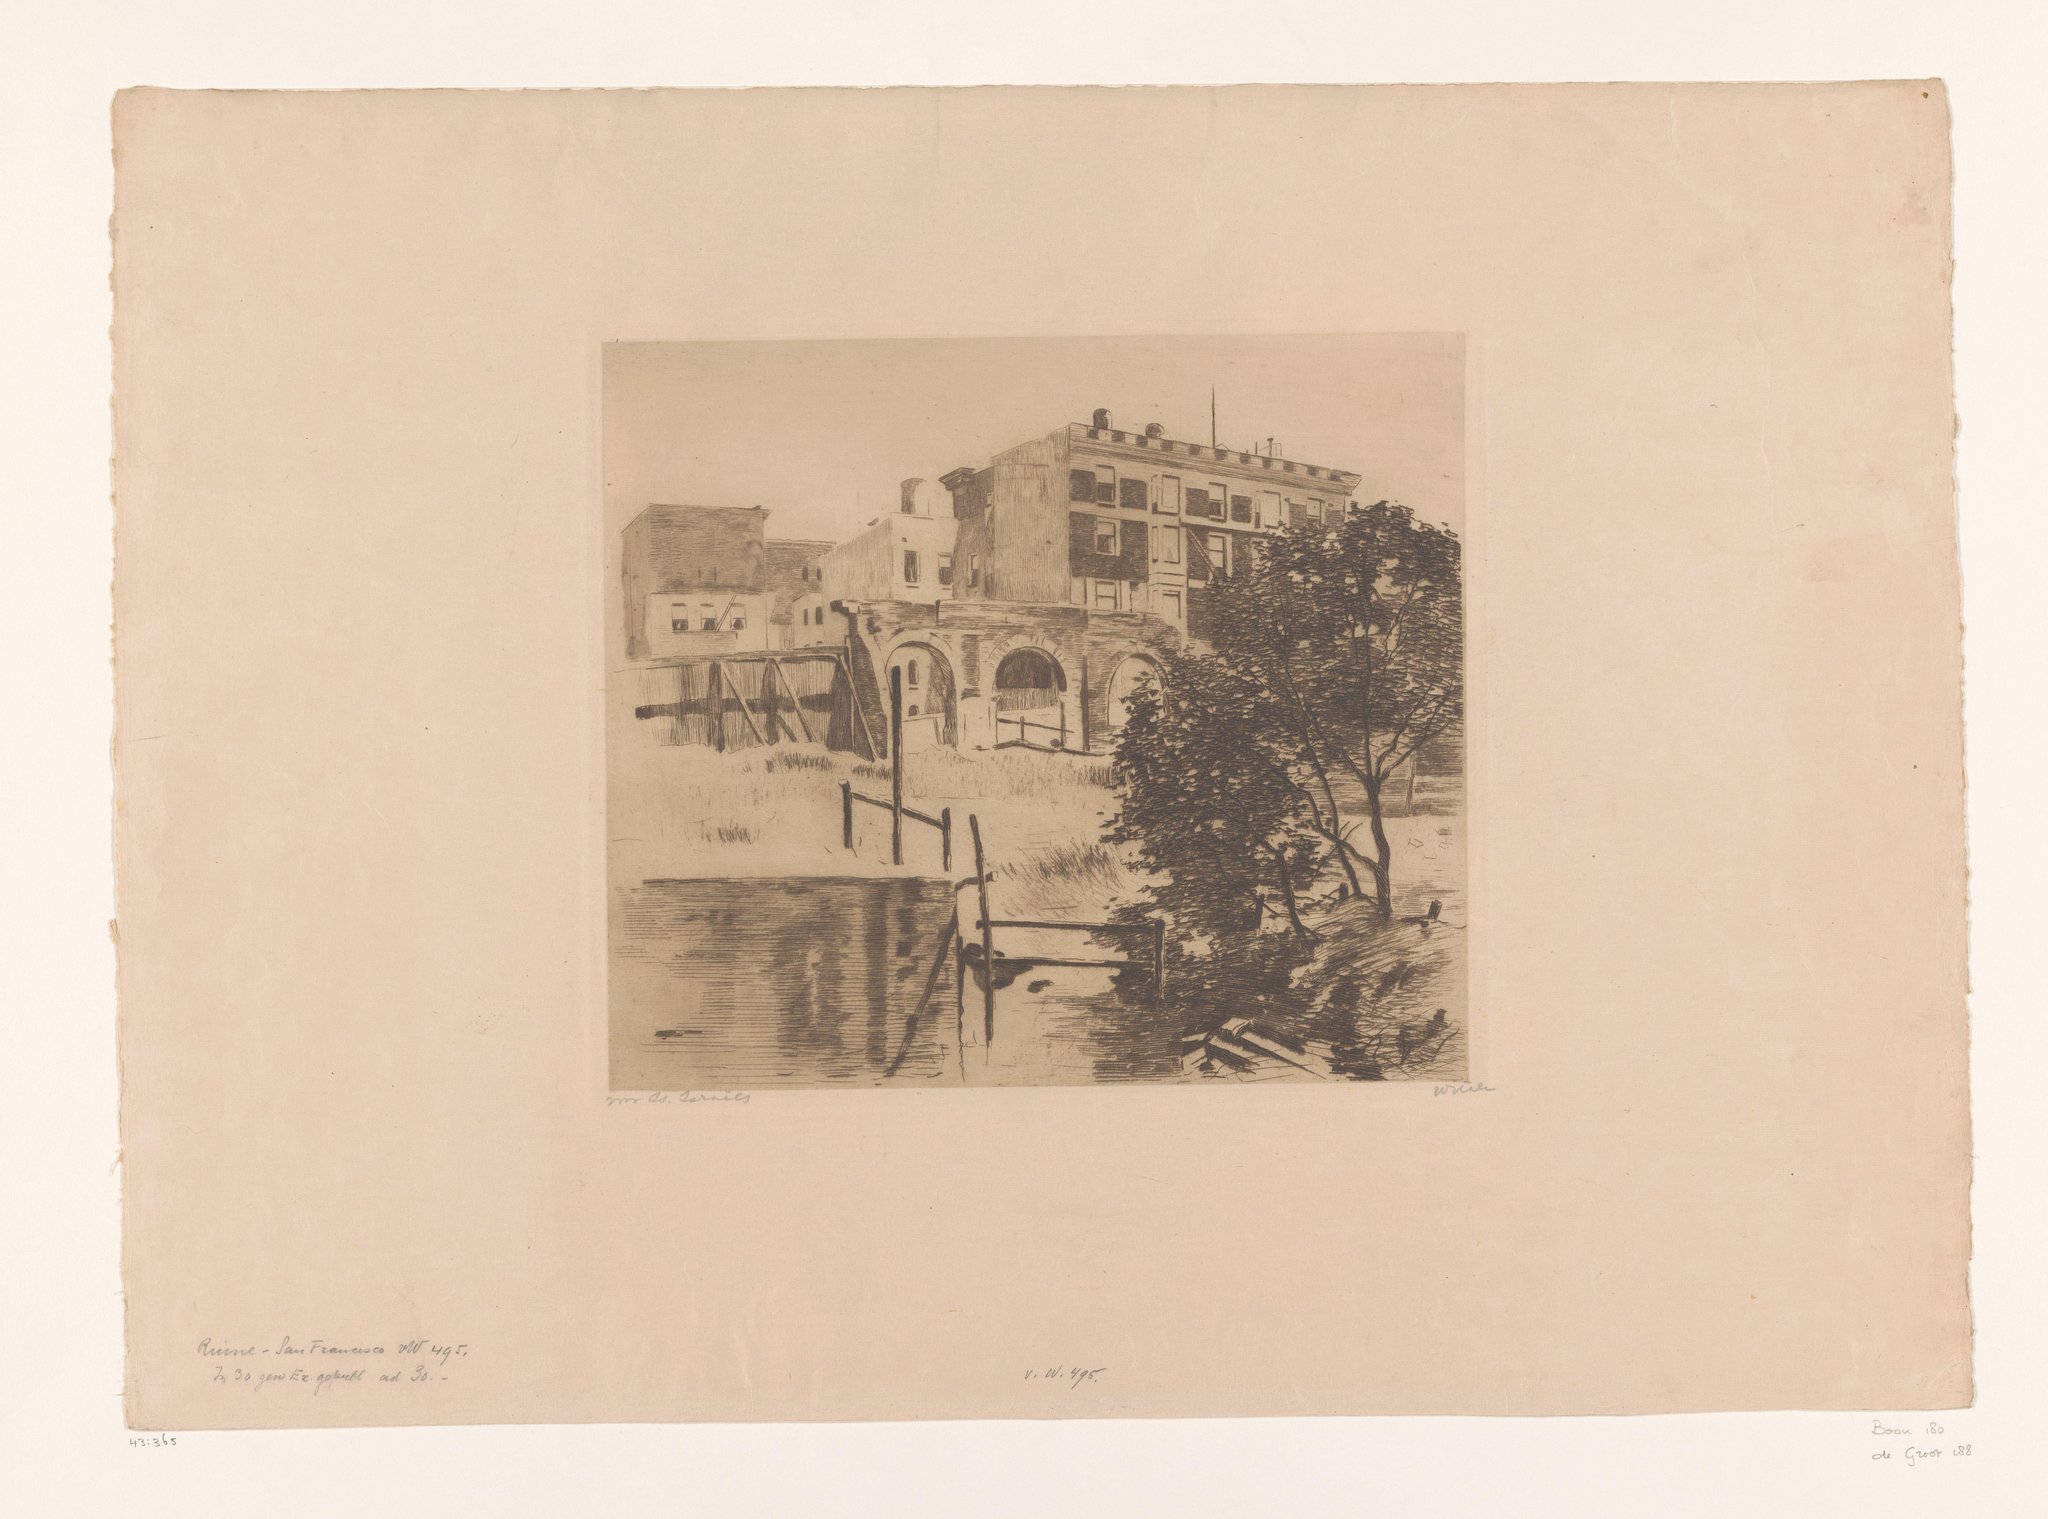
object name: print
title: Gezicht op een ruïne in San Francisco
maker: willem witsen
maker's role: draughtsman, painter, print maker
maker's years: 1860-1923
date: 1915-1919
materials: paper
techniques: aquatint, etching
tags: ruin of a building ~ architecture, collapsing building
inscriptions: collector's mark: Lugt 2228, collector's mark: Lugt 2760, annotation: ‘Pont Street San Francisco vW 495./ In 30 gew Ex gepubl ad fl. 30,-’, dedication: ‘voor Is. Israëls’